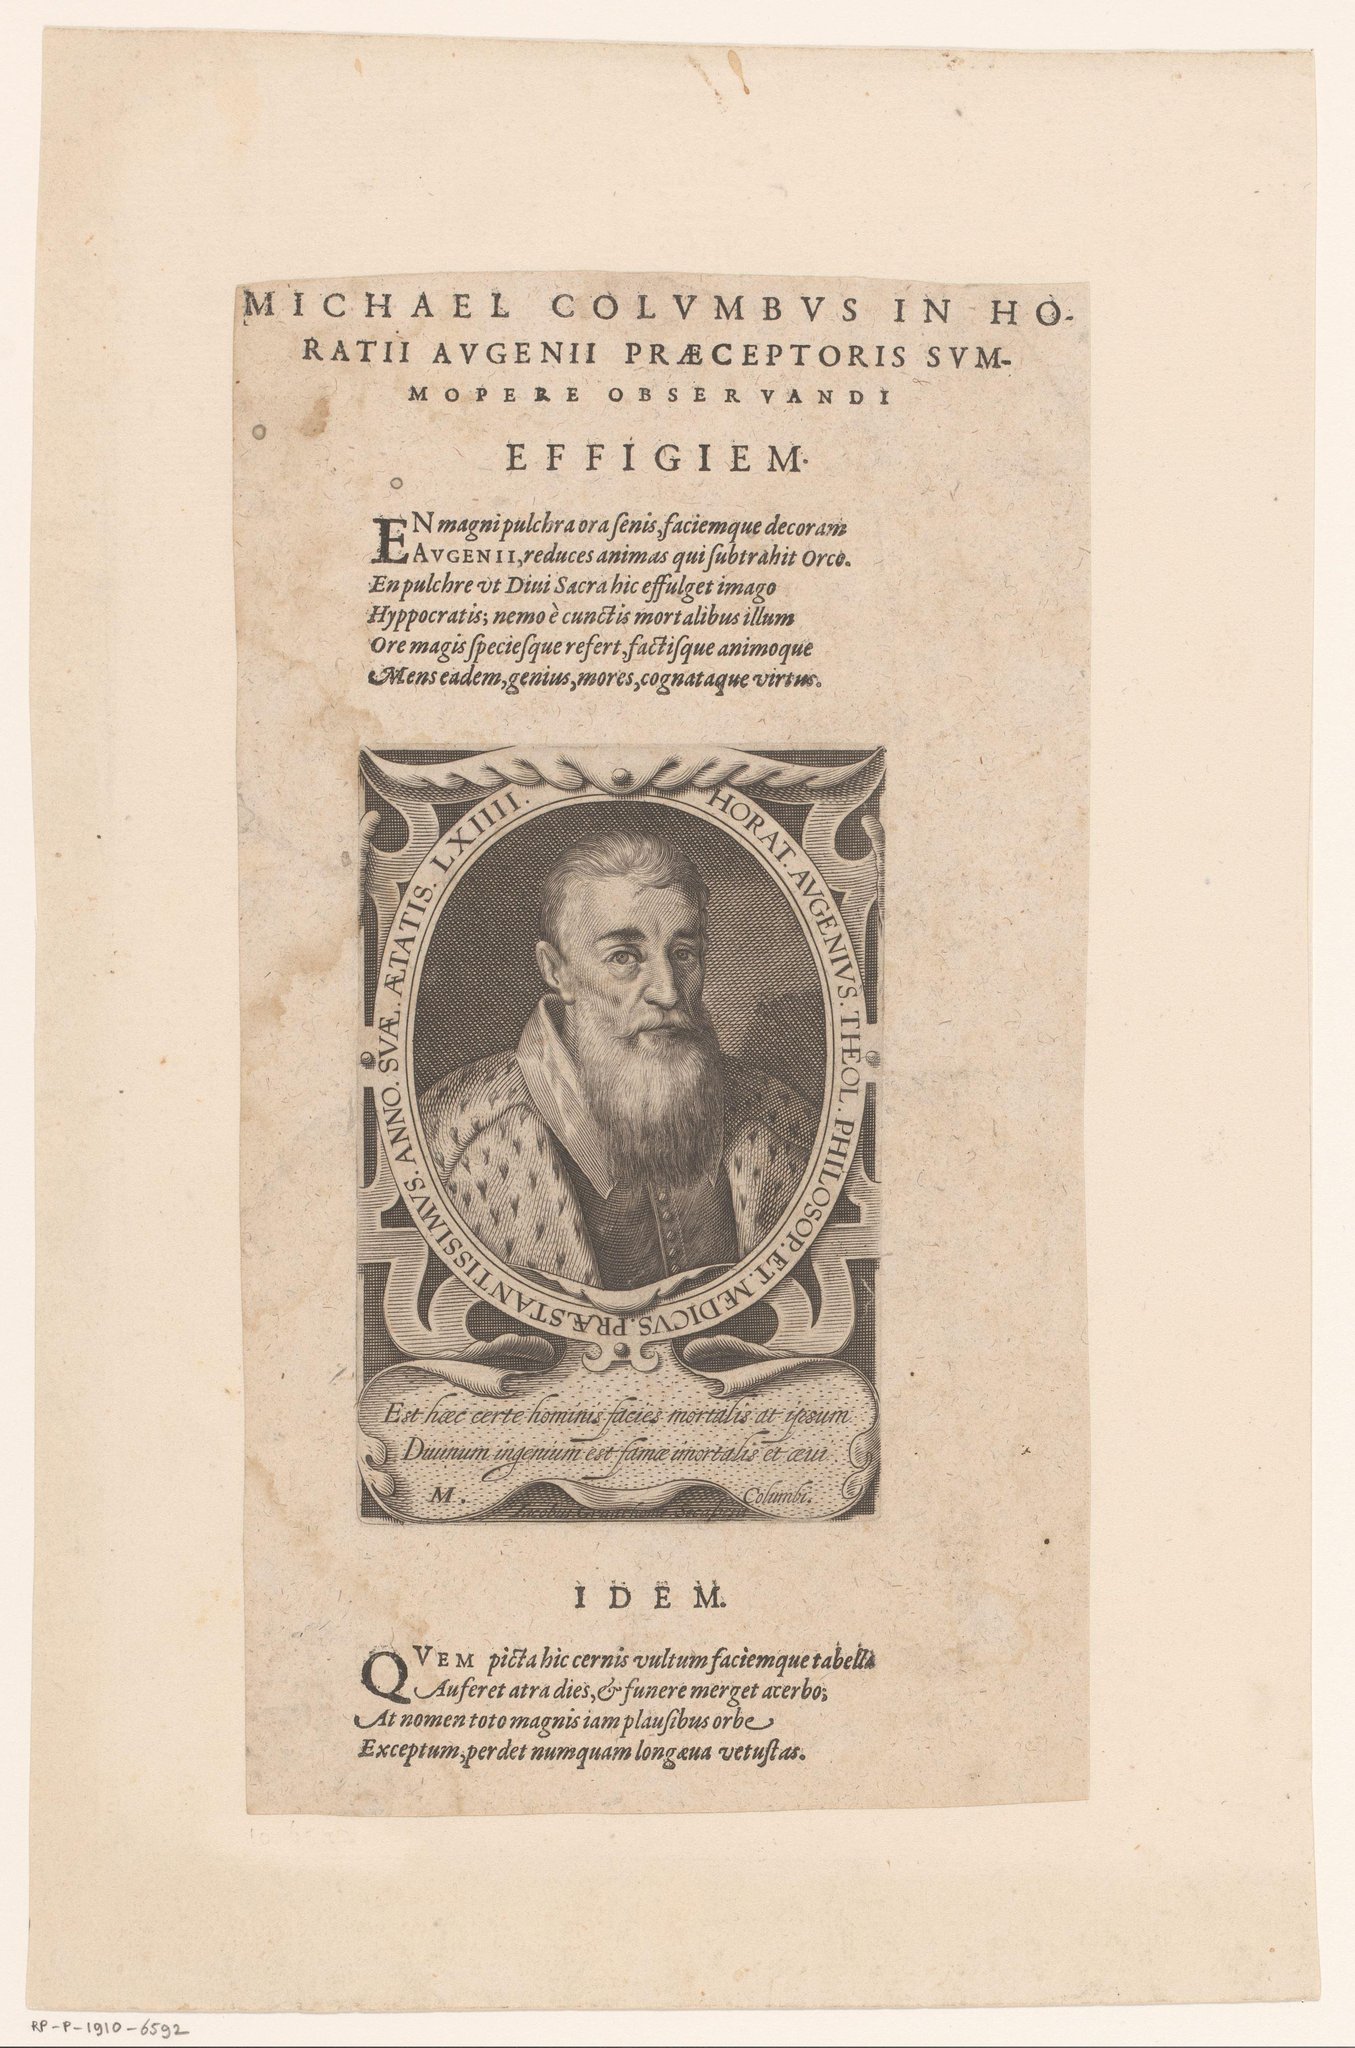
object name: book illustration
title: Portret van Orazio Augenio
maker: jacques granthomme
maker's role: print maker, publisher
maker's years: 1550-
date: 1588-1622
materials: paper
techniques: engraving, letterpress printing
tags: historical persons, physician, doctor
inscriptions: collector's mark: Lugt 2228